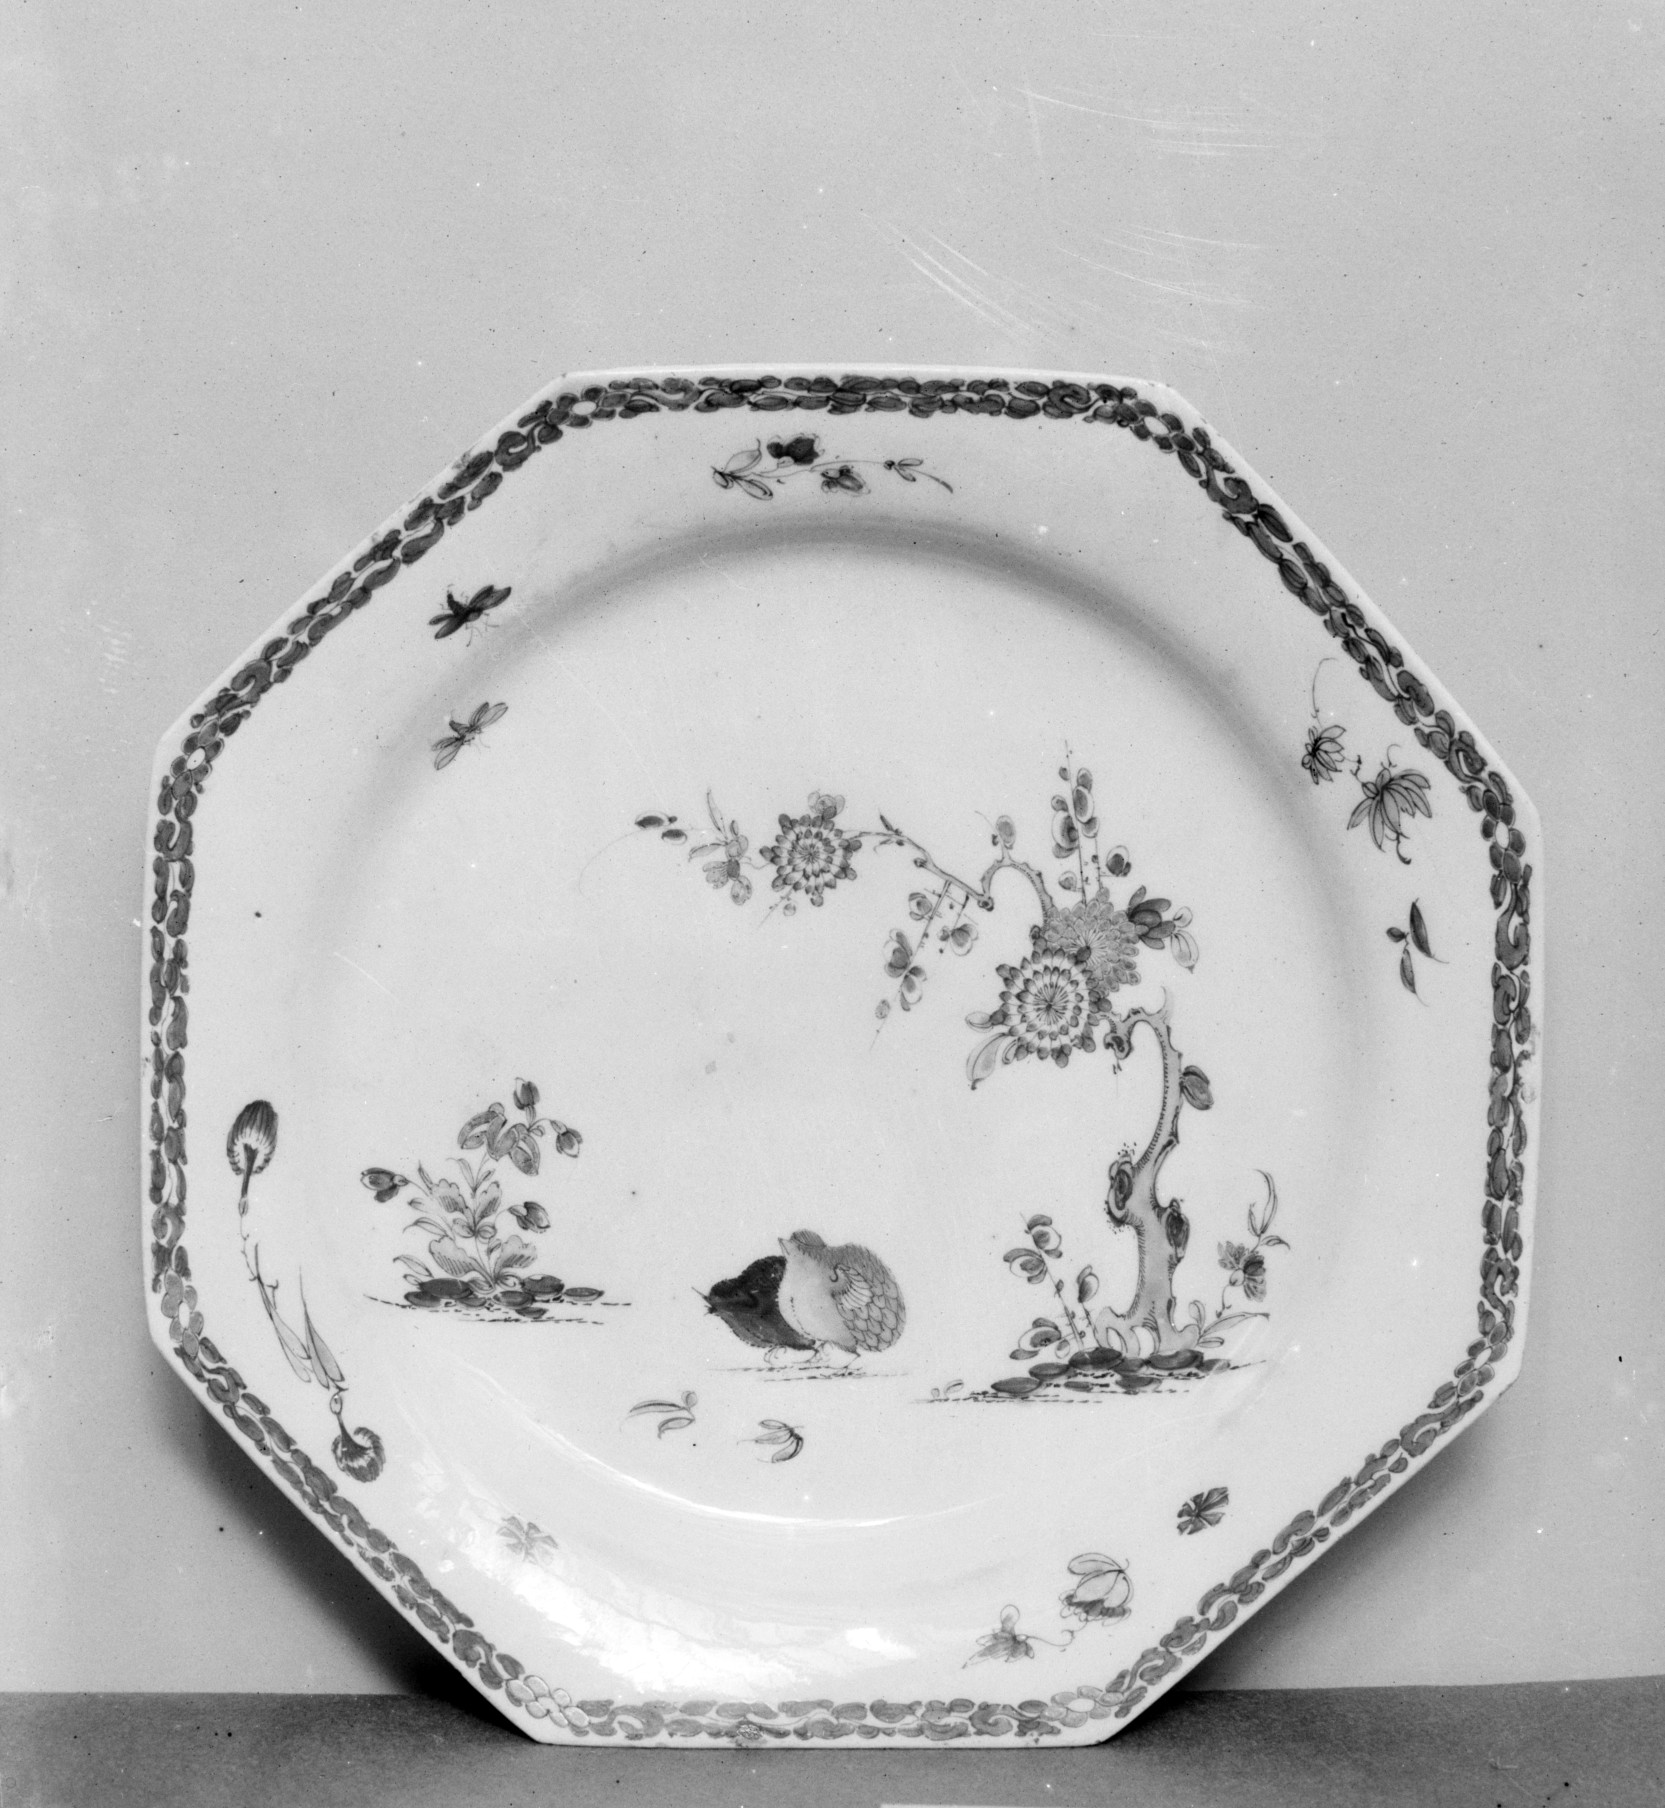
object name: plate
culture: british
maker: bow porcelain factory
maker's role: manufacturer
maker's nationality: british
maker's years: 1747-1776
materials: paste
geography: england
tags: flowers